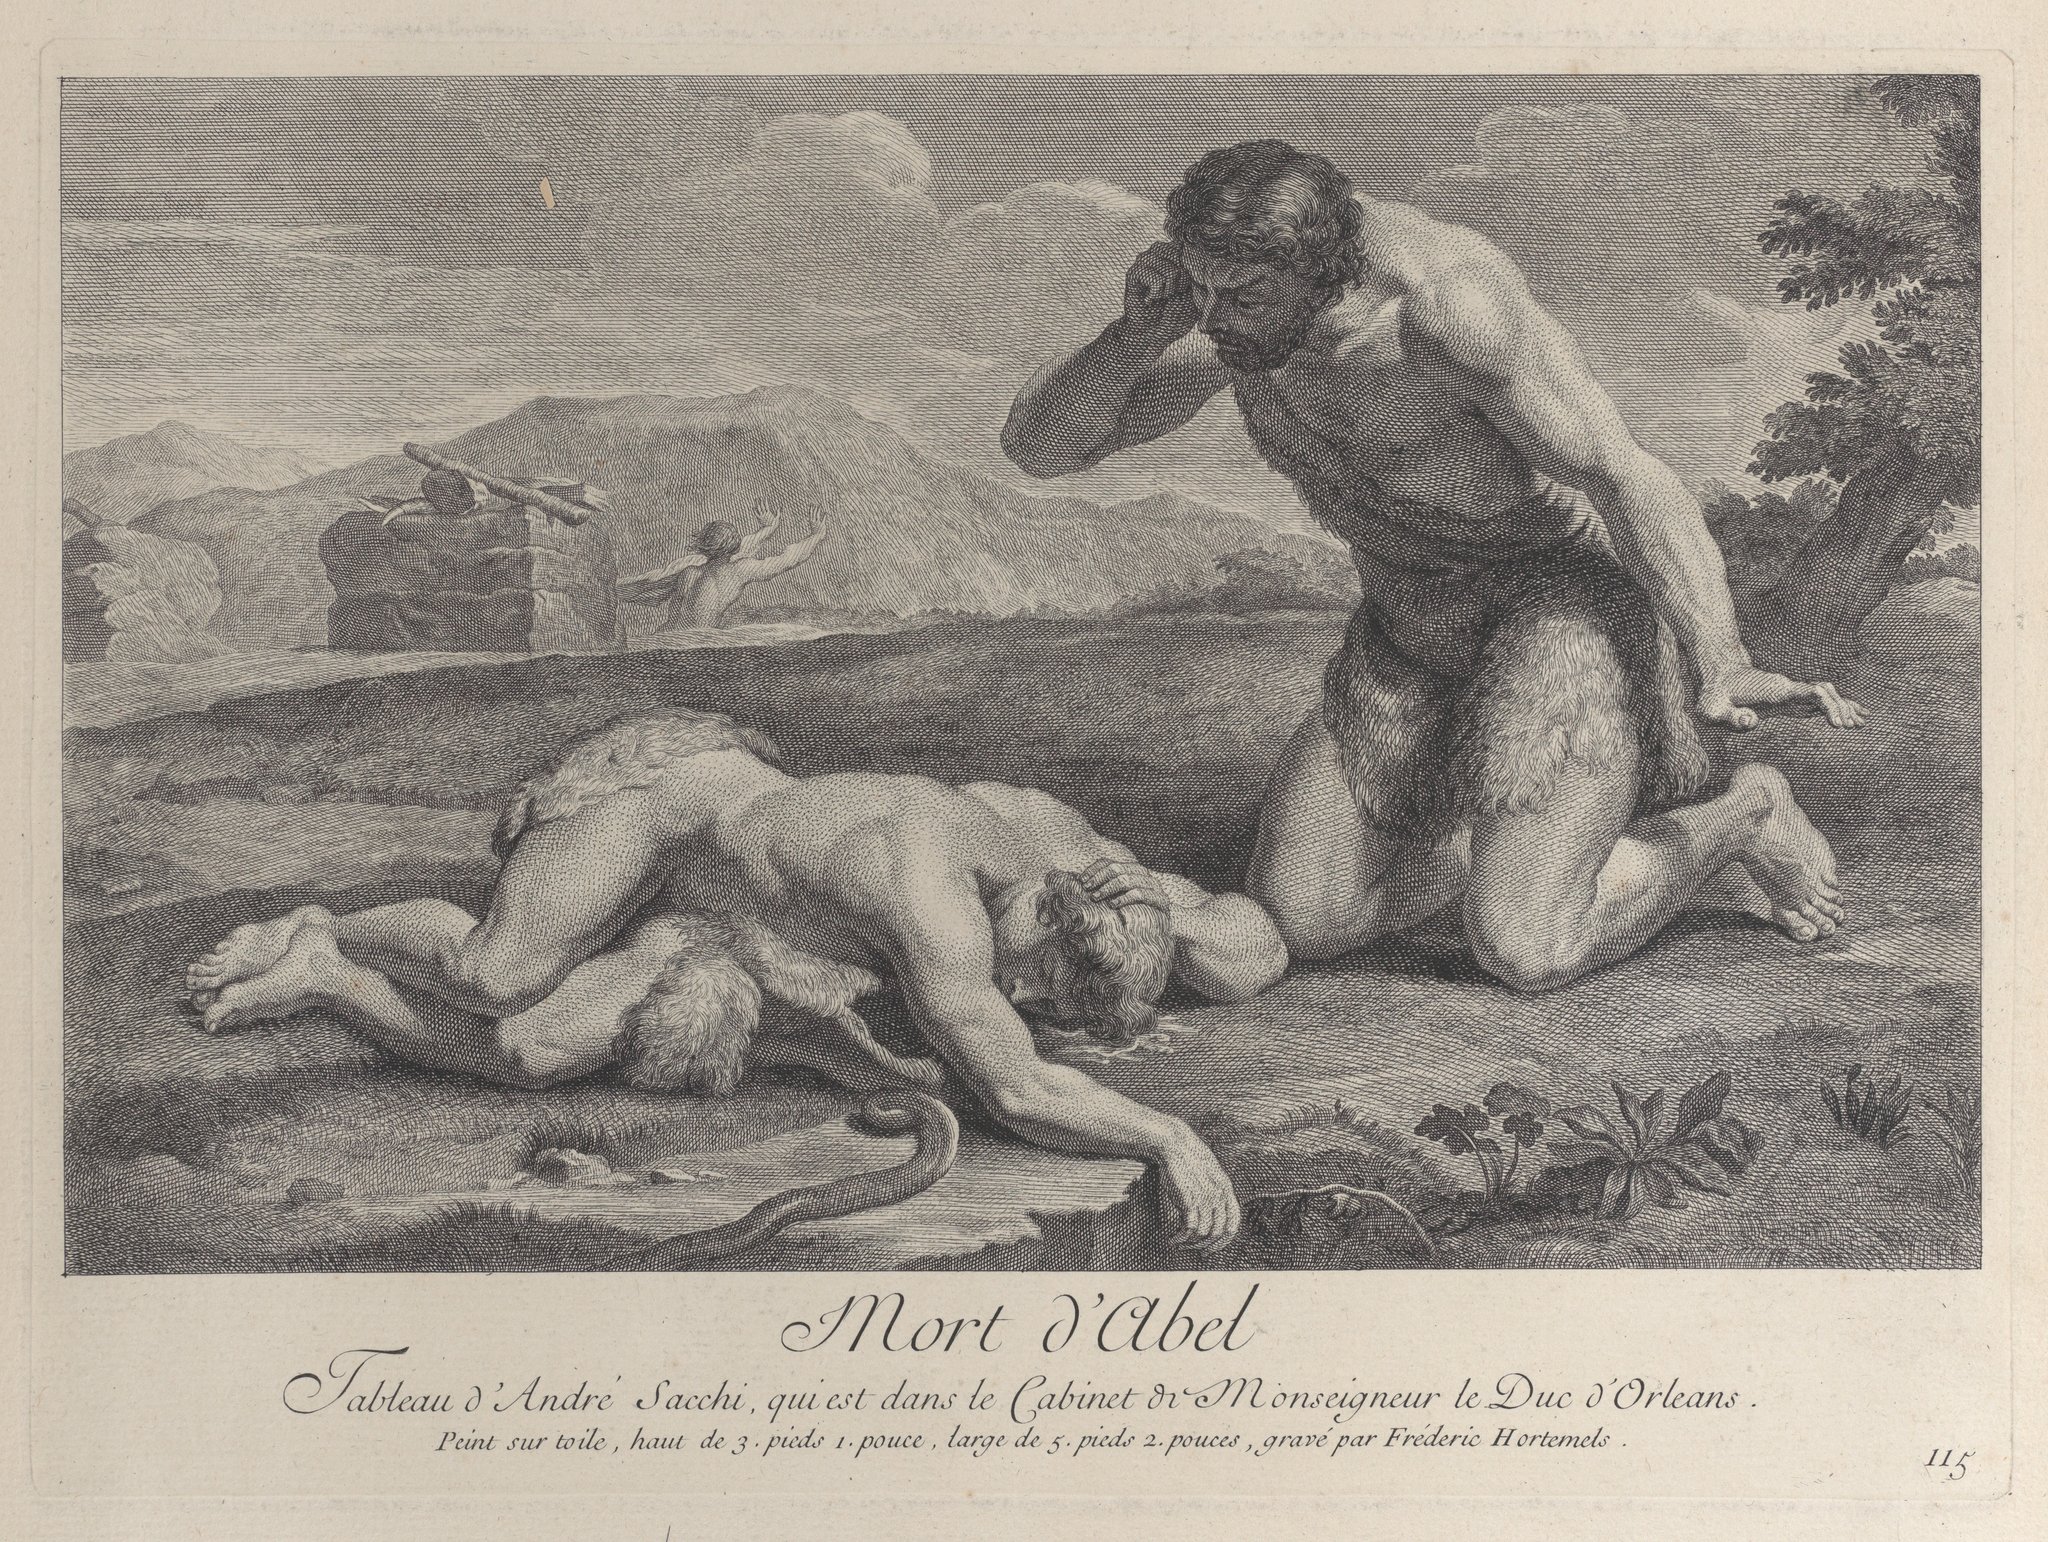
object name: print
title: Adam kneels in grief beside the body of Abel, while Cain flees in the background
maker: frédéric horthemels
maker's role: artist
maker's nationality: french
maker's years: 1680-1738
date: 1729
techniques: engraving, etching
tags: men,abel,cain,adam